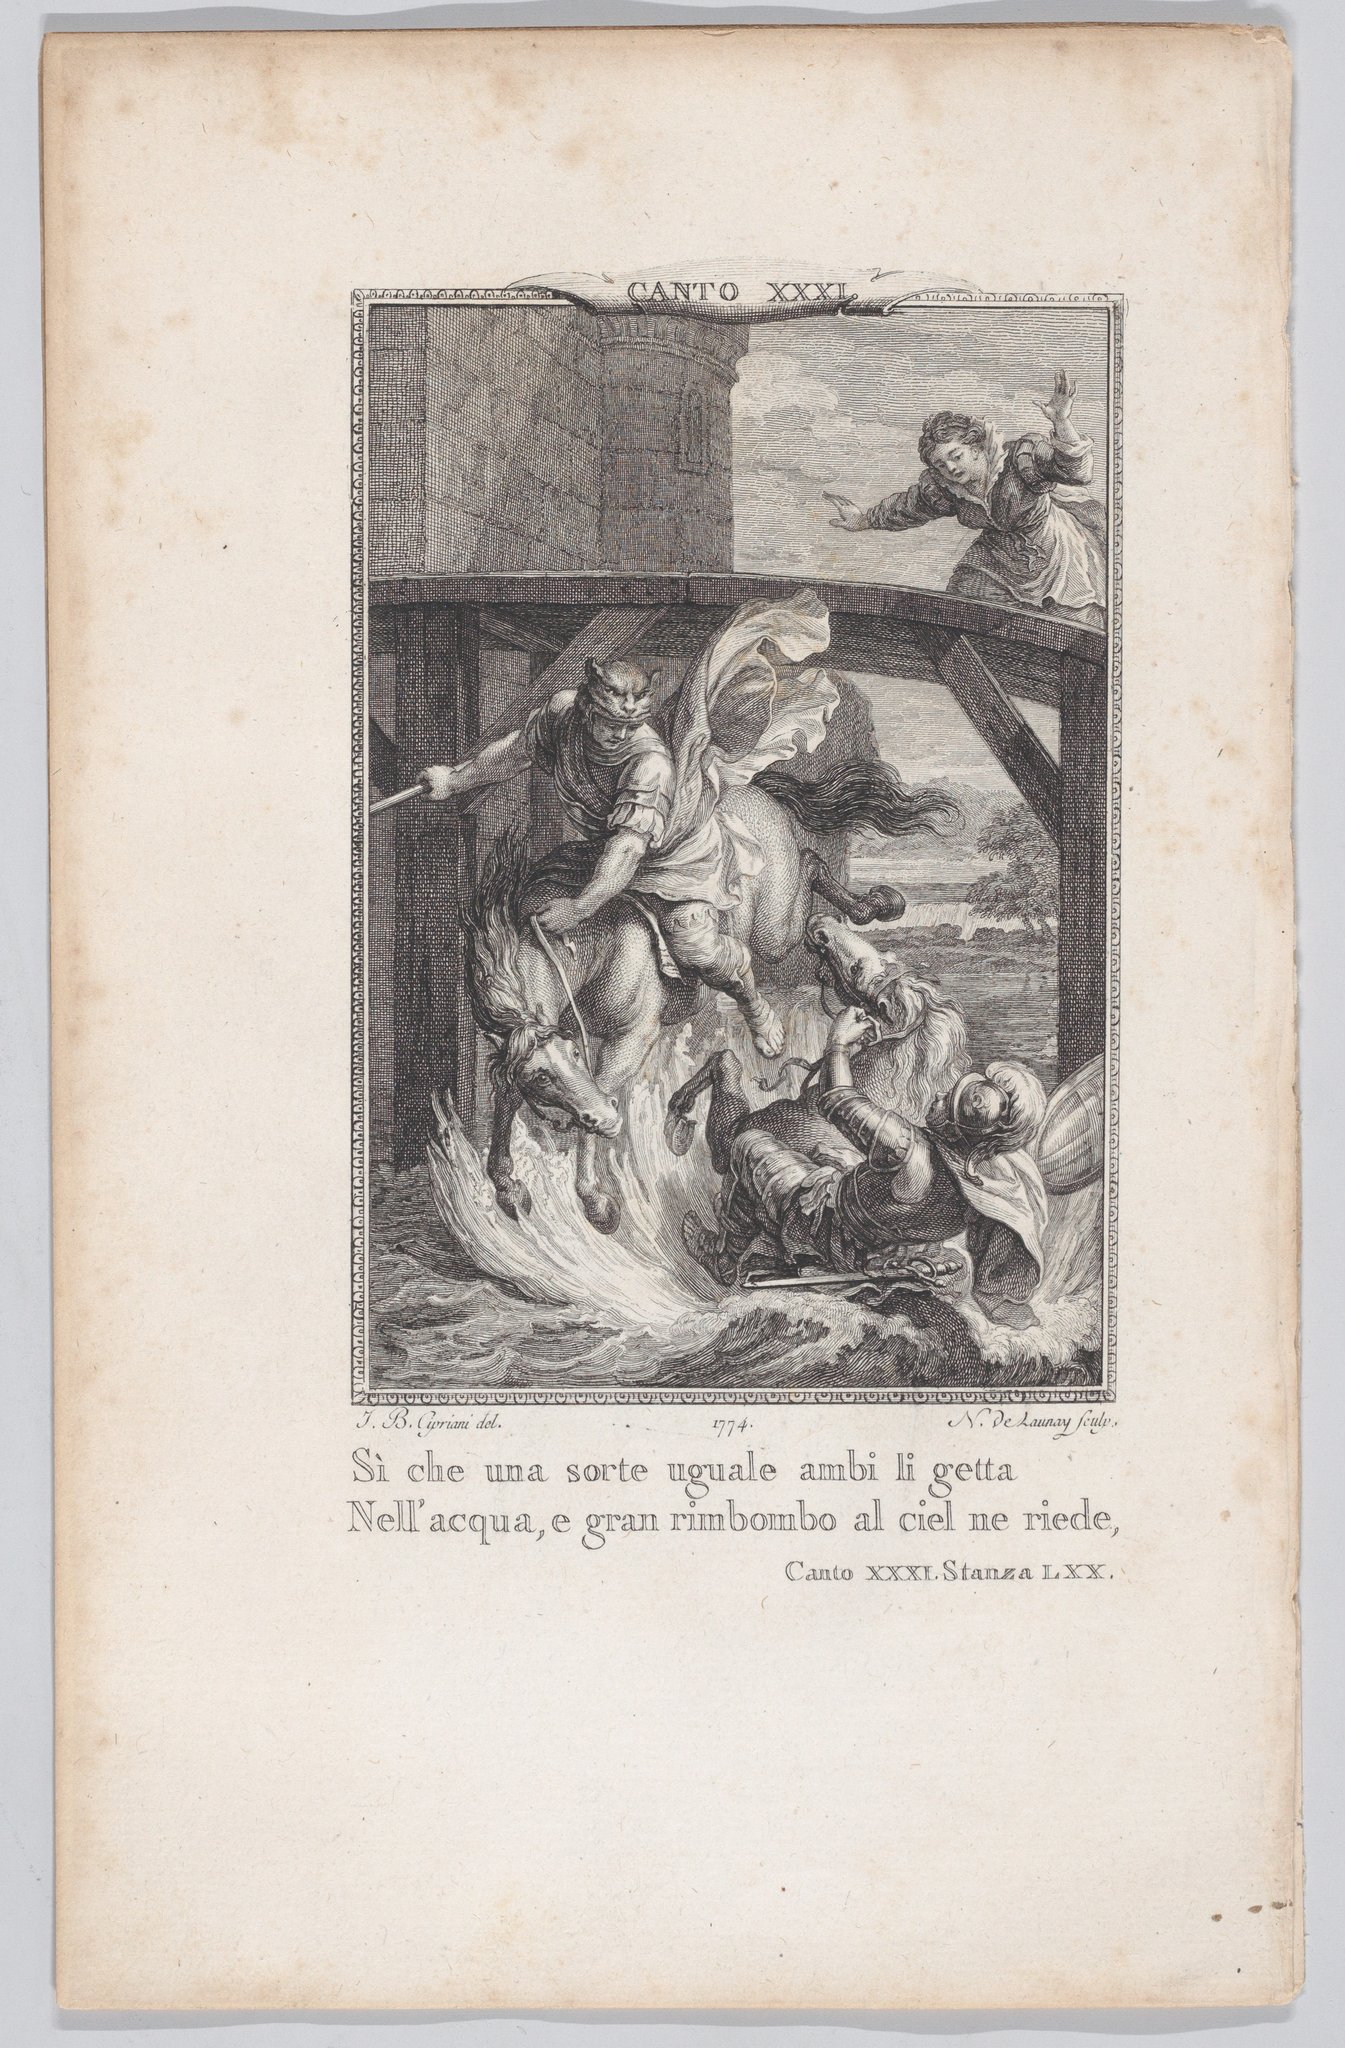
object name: print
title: Canto 31, Stanza 70, from "Orlando Furioso"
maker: nicolas de launay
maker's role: artist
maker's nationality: french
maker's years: 1739-1792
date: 1774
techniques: engraving, etching